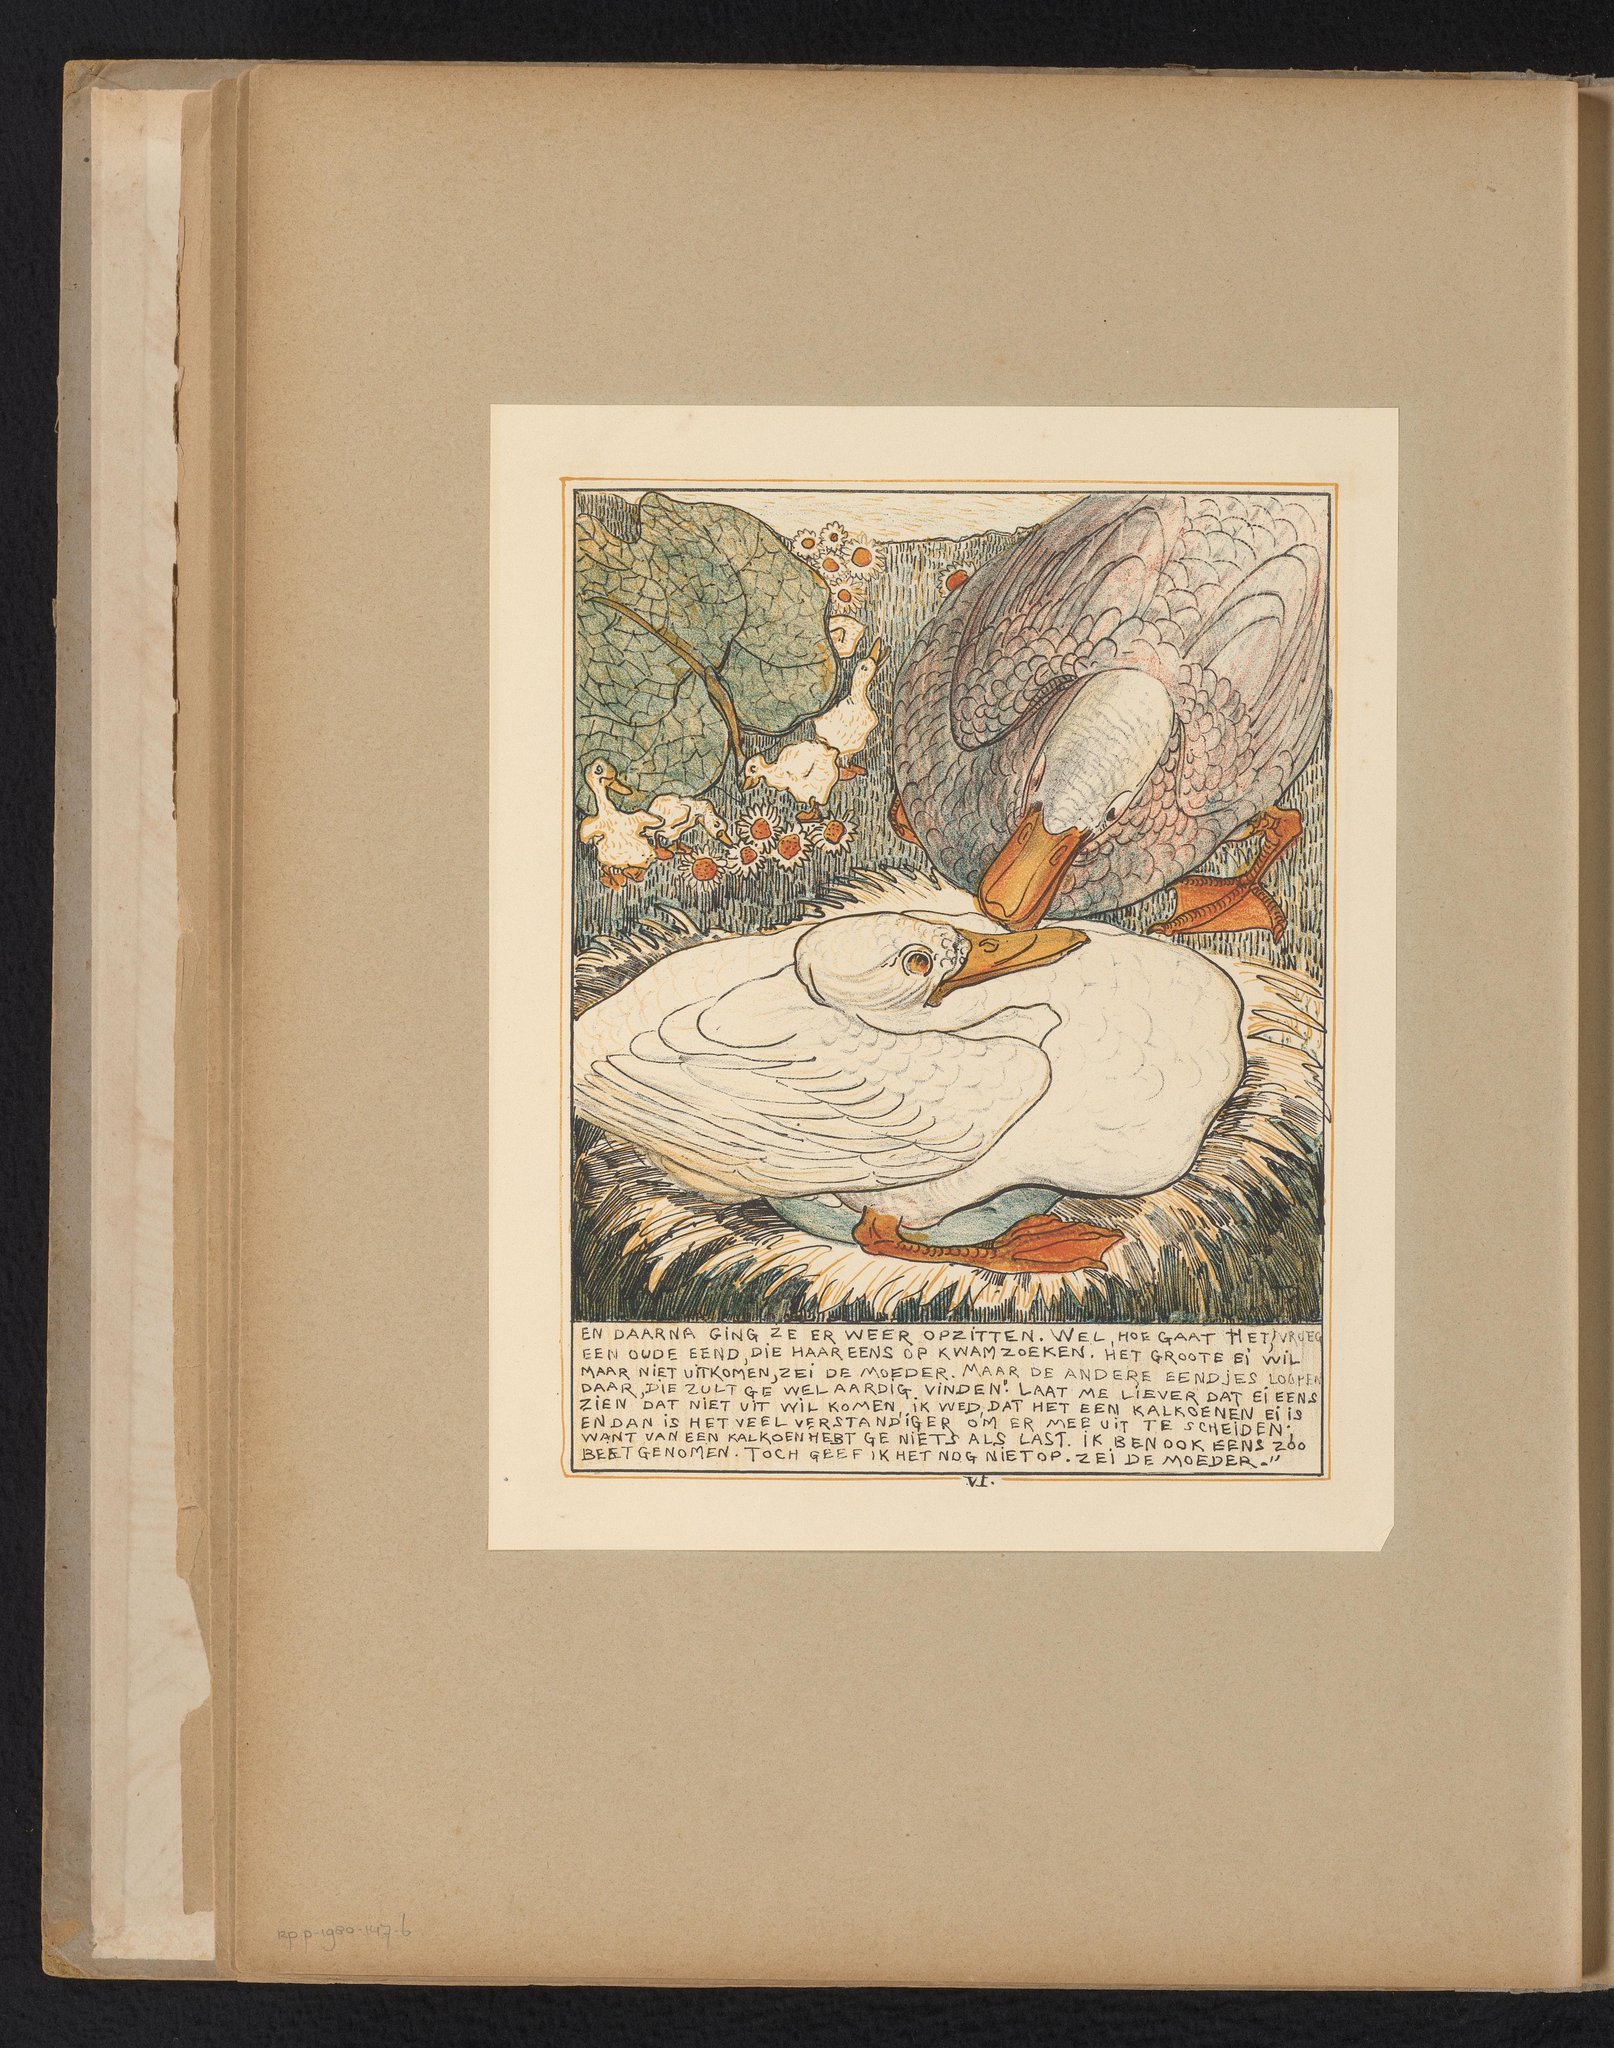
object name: print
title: Het leelijke jonge eendje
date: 1893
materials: paper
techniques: lithograph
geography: the hague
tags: water-birds: duck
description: De al uitgekomen jongen op de achtergrond, en een tweede eend bij de moedereend. Deze prent maakt deel uit van een album.